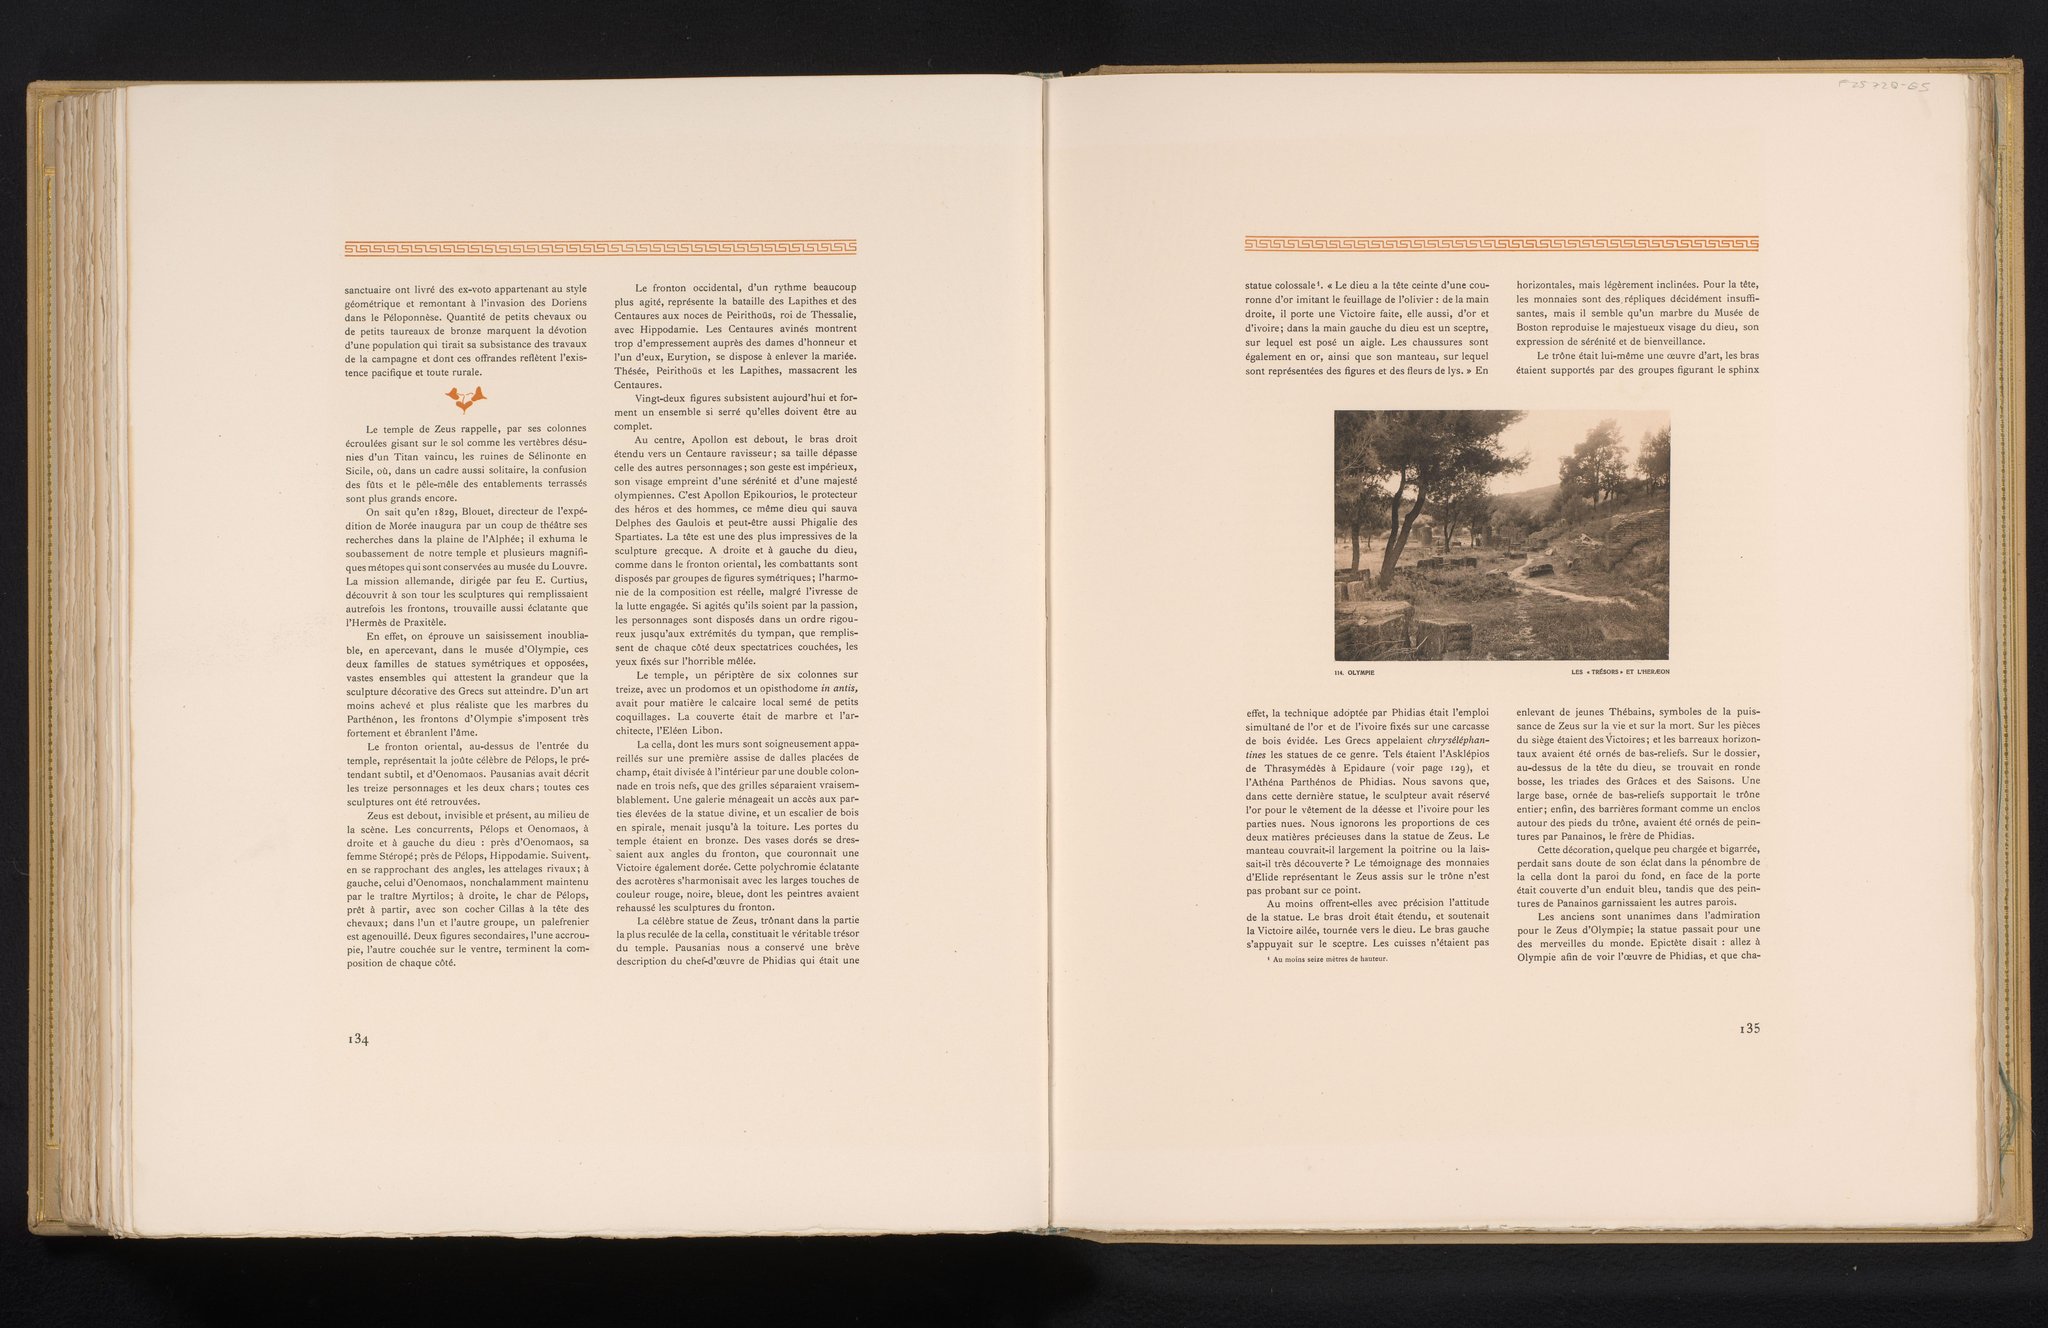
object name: photomechanical print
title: Ruïne van de Tempel van Hera in Olympia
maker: frédéric boissonnas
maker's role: fotograaf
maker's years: 1858-1946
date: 1905-1910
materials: paper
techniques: photograph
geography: berlin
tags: landscape with ruins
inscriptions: number: ‘114.’